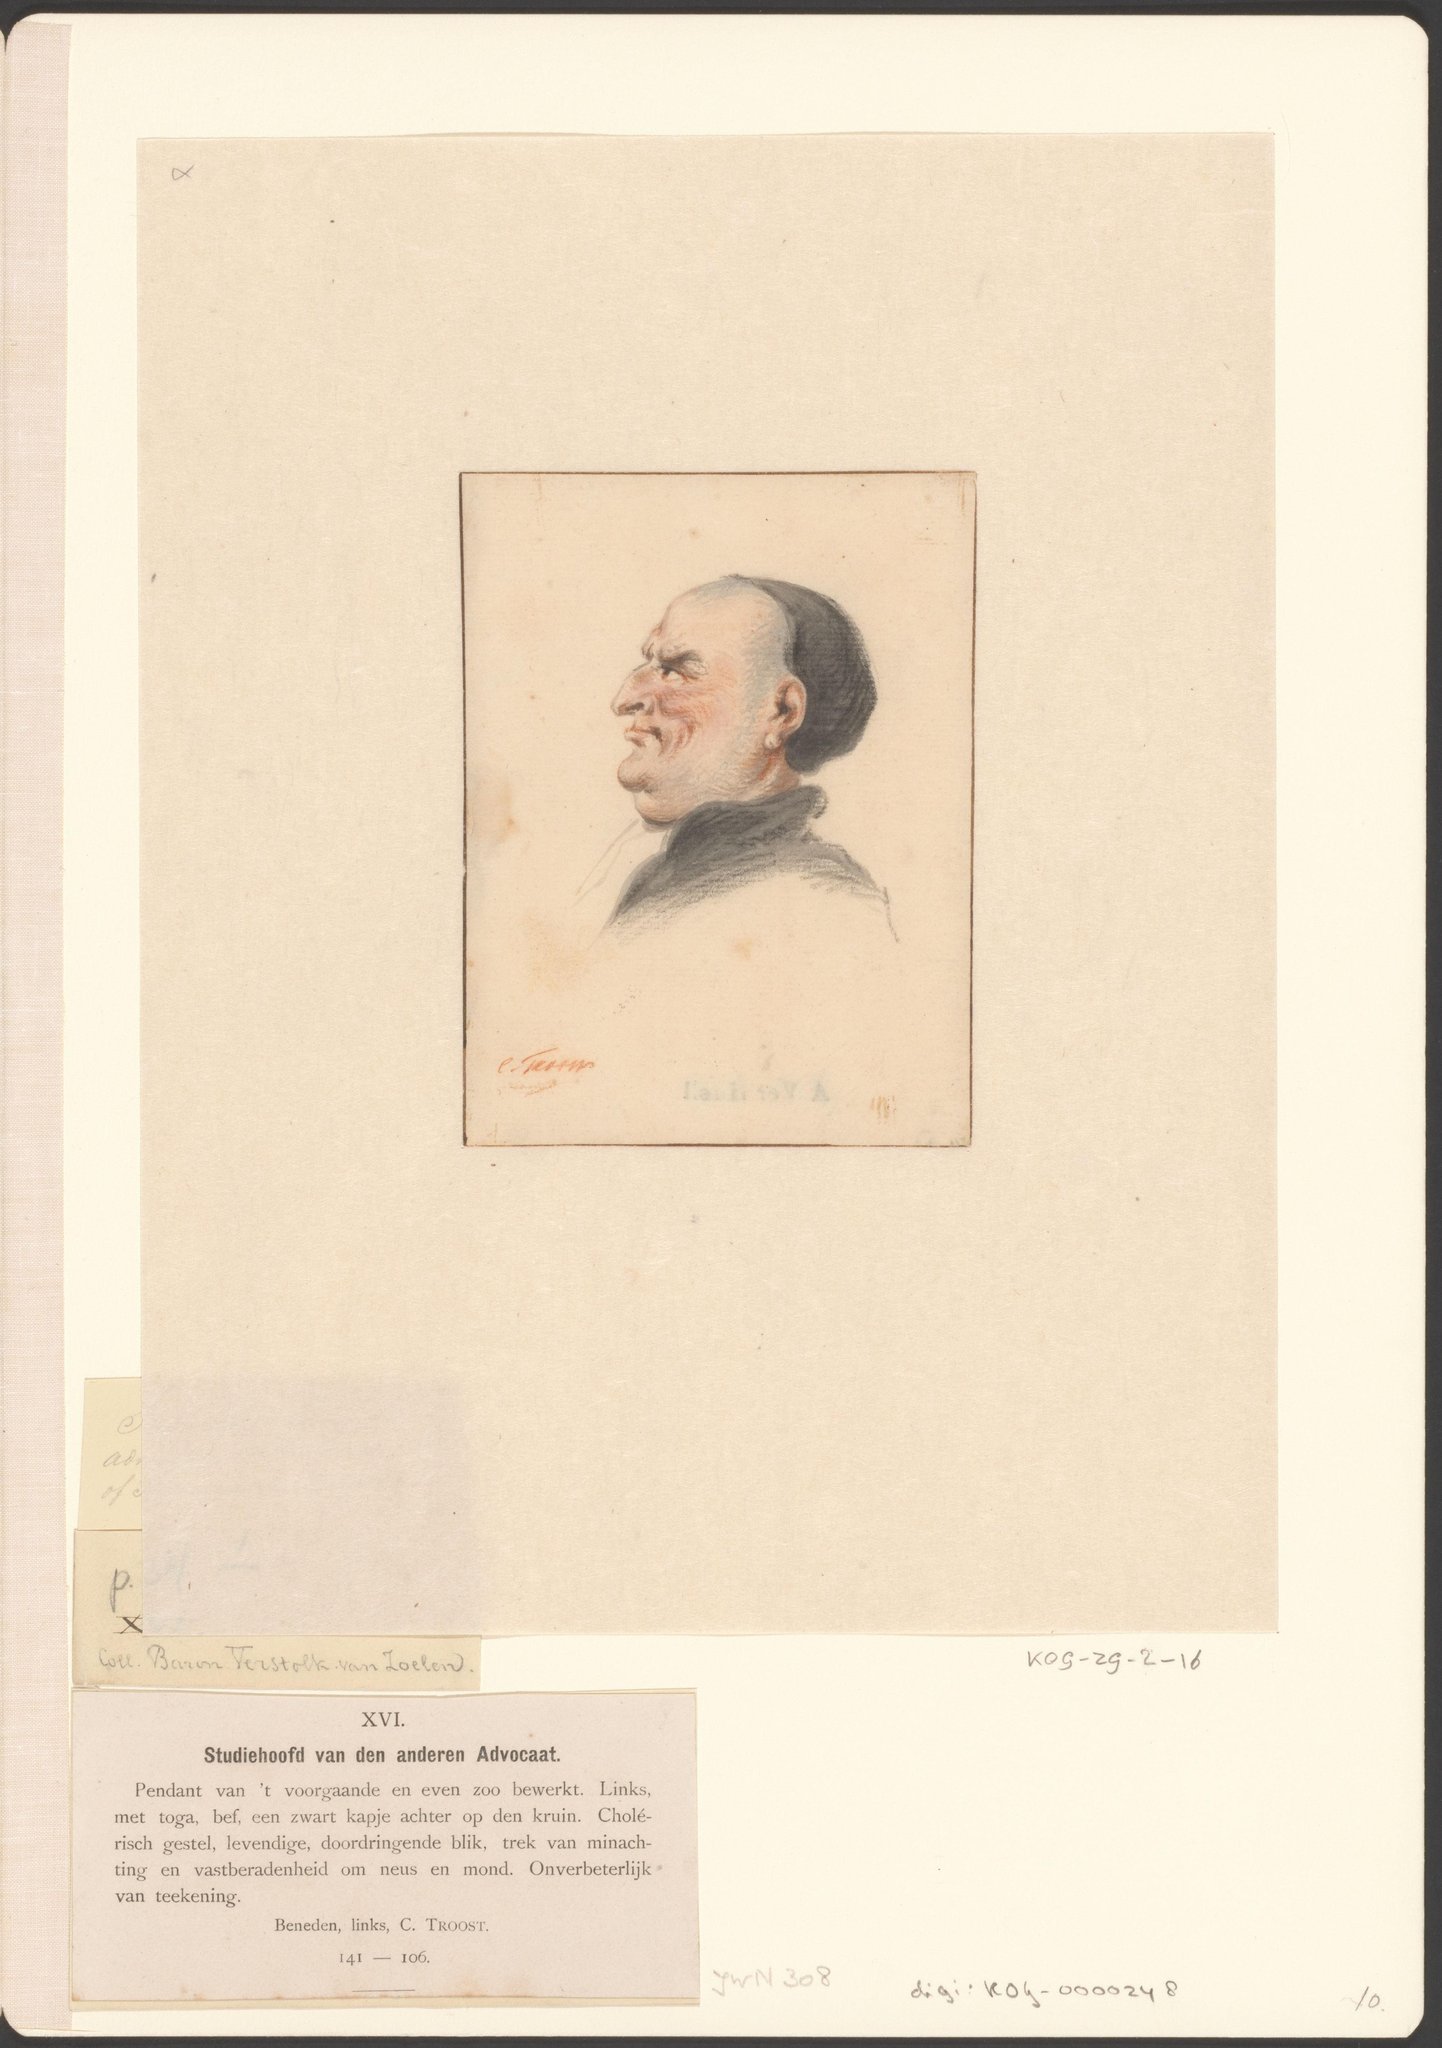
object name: drawing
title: Studie van de advocaat Jacobus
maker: cornelis troost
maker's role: draughtsman, painter, print maker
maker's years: 1696-1750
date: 1741-1745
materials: chalk, ink, paper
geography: netherlands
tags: lawyer, attorney at law, head turned to the left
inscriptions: collector's mark: Lugt 2488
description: De advocaat Jacobus. Hoofd in profiel naar links. Naar het schilderij 'Beslikte Swaantje voor de Puiterveense Rechtbank'.